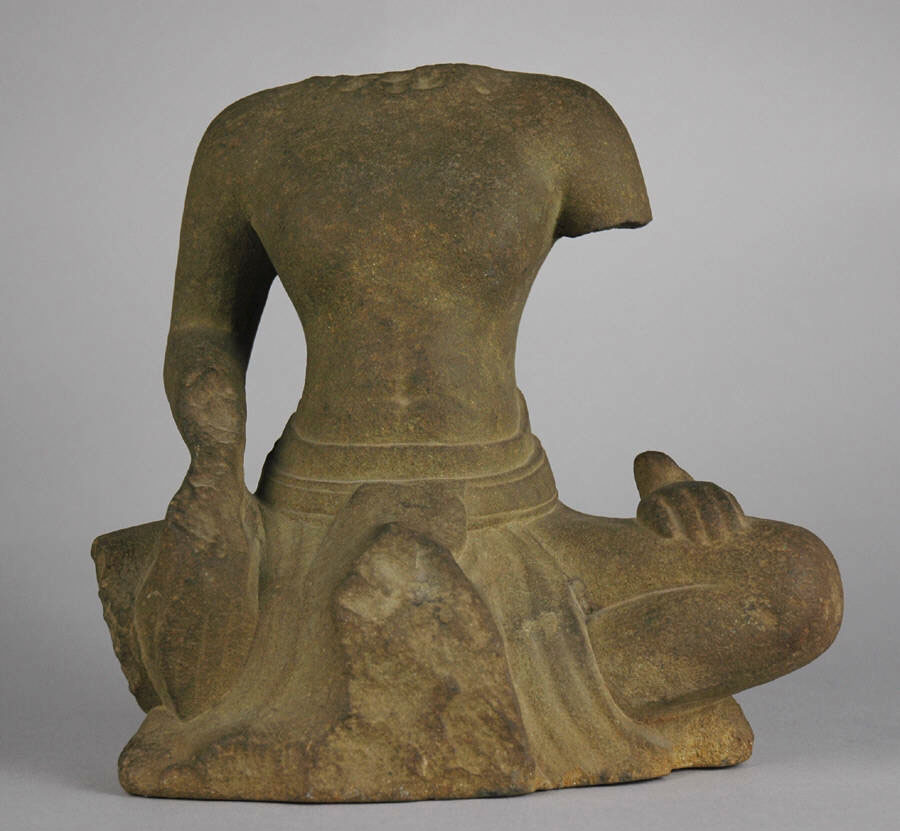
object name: fragment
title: Seated Male Figure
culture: vietnamese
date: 501-600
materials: stone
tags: men